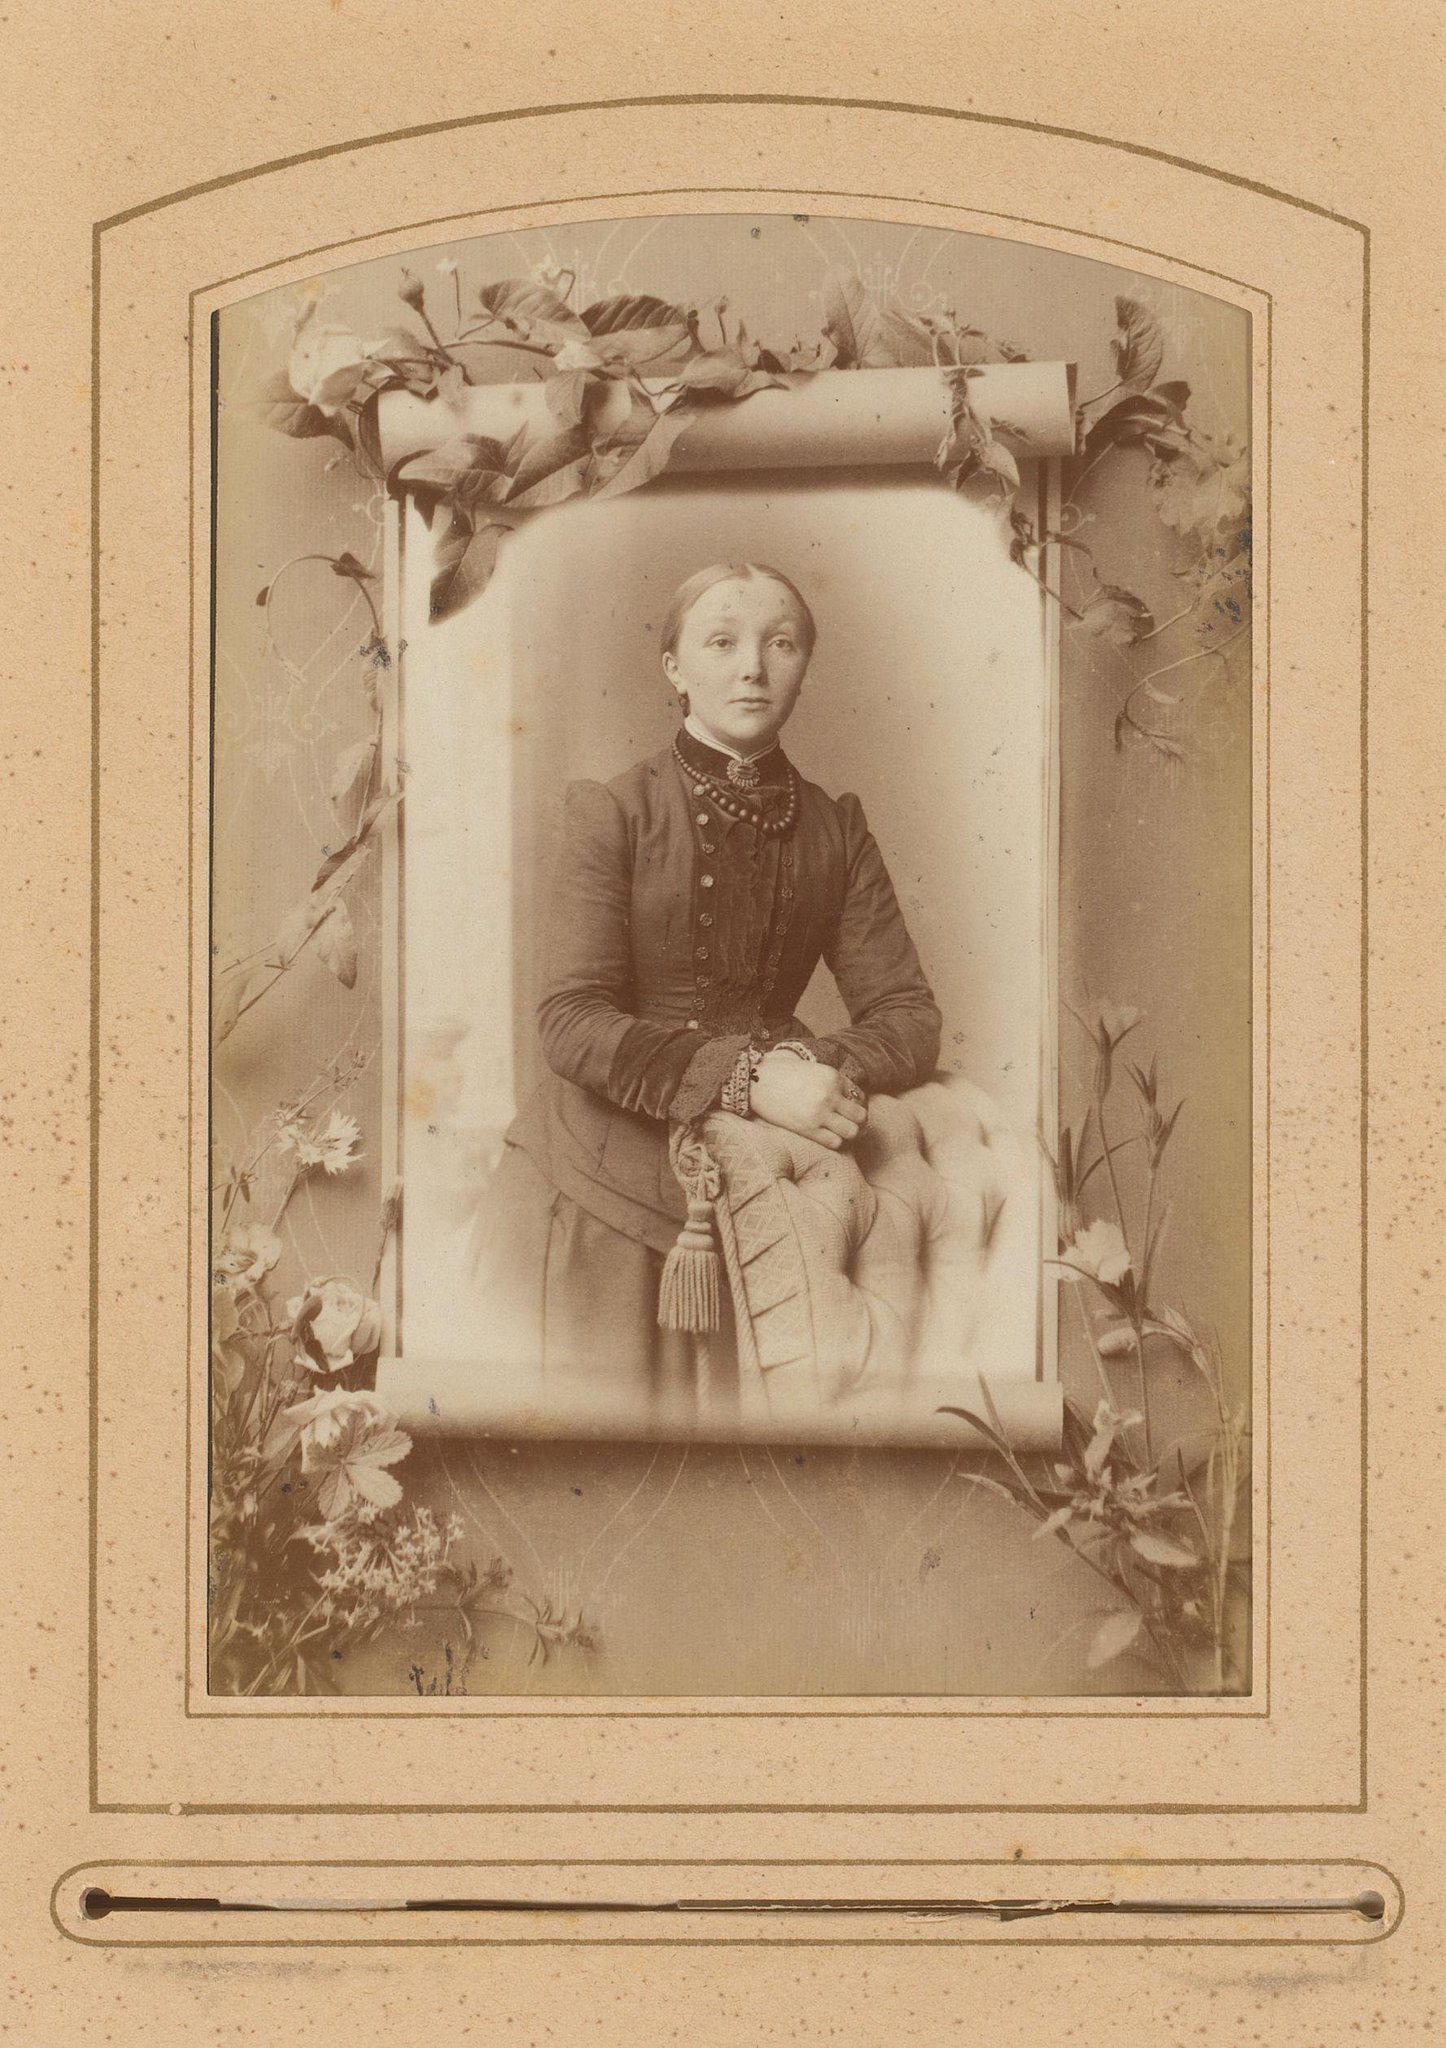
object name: album leaf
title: Fotomontage van een geportretteerde vrouw in een gedecoreerde lijst met bloemen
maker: willem oldenkamp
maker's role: fotograaf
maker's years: 1864-1921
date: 1885-1915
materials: cardboard, photographic support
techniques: albumen print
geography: netherlands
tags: historical persons - bb - woman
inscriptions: inscription: ‘W. Oldenkamp/ Arnhem/ Wageningen’